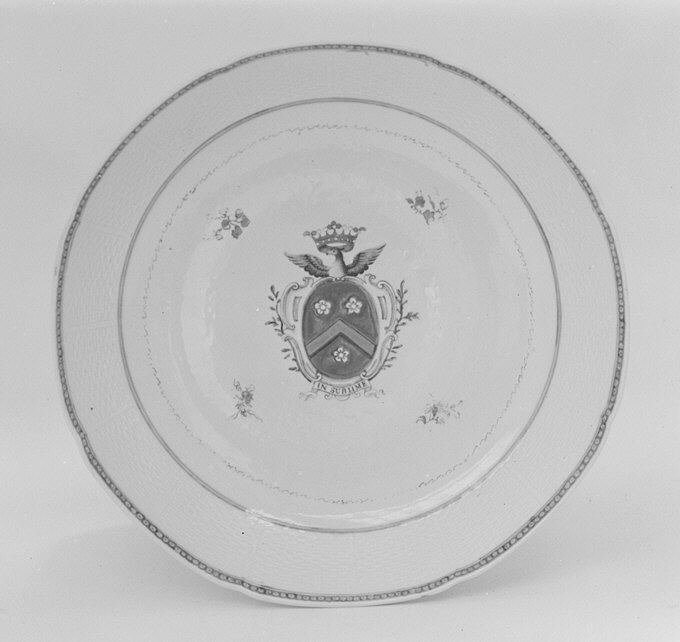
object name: dish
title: Deep dish (part of a service)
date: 1770-1785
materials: hard paste porcelain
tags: birds,coat of arms